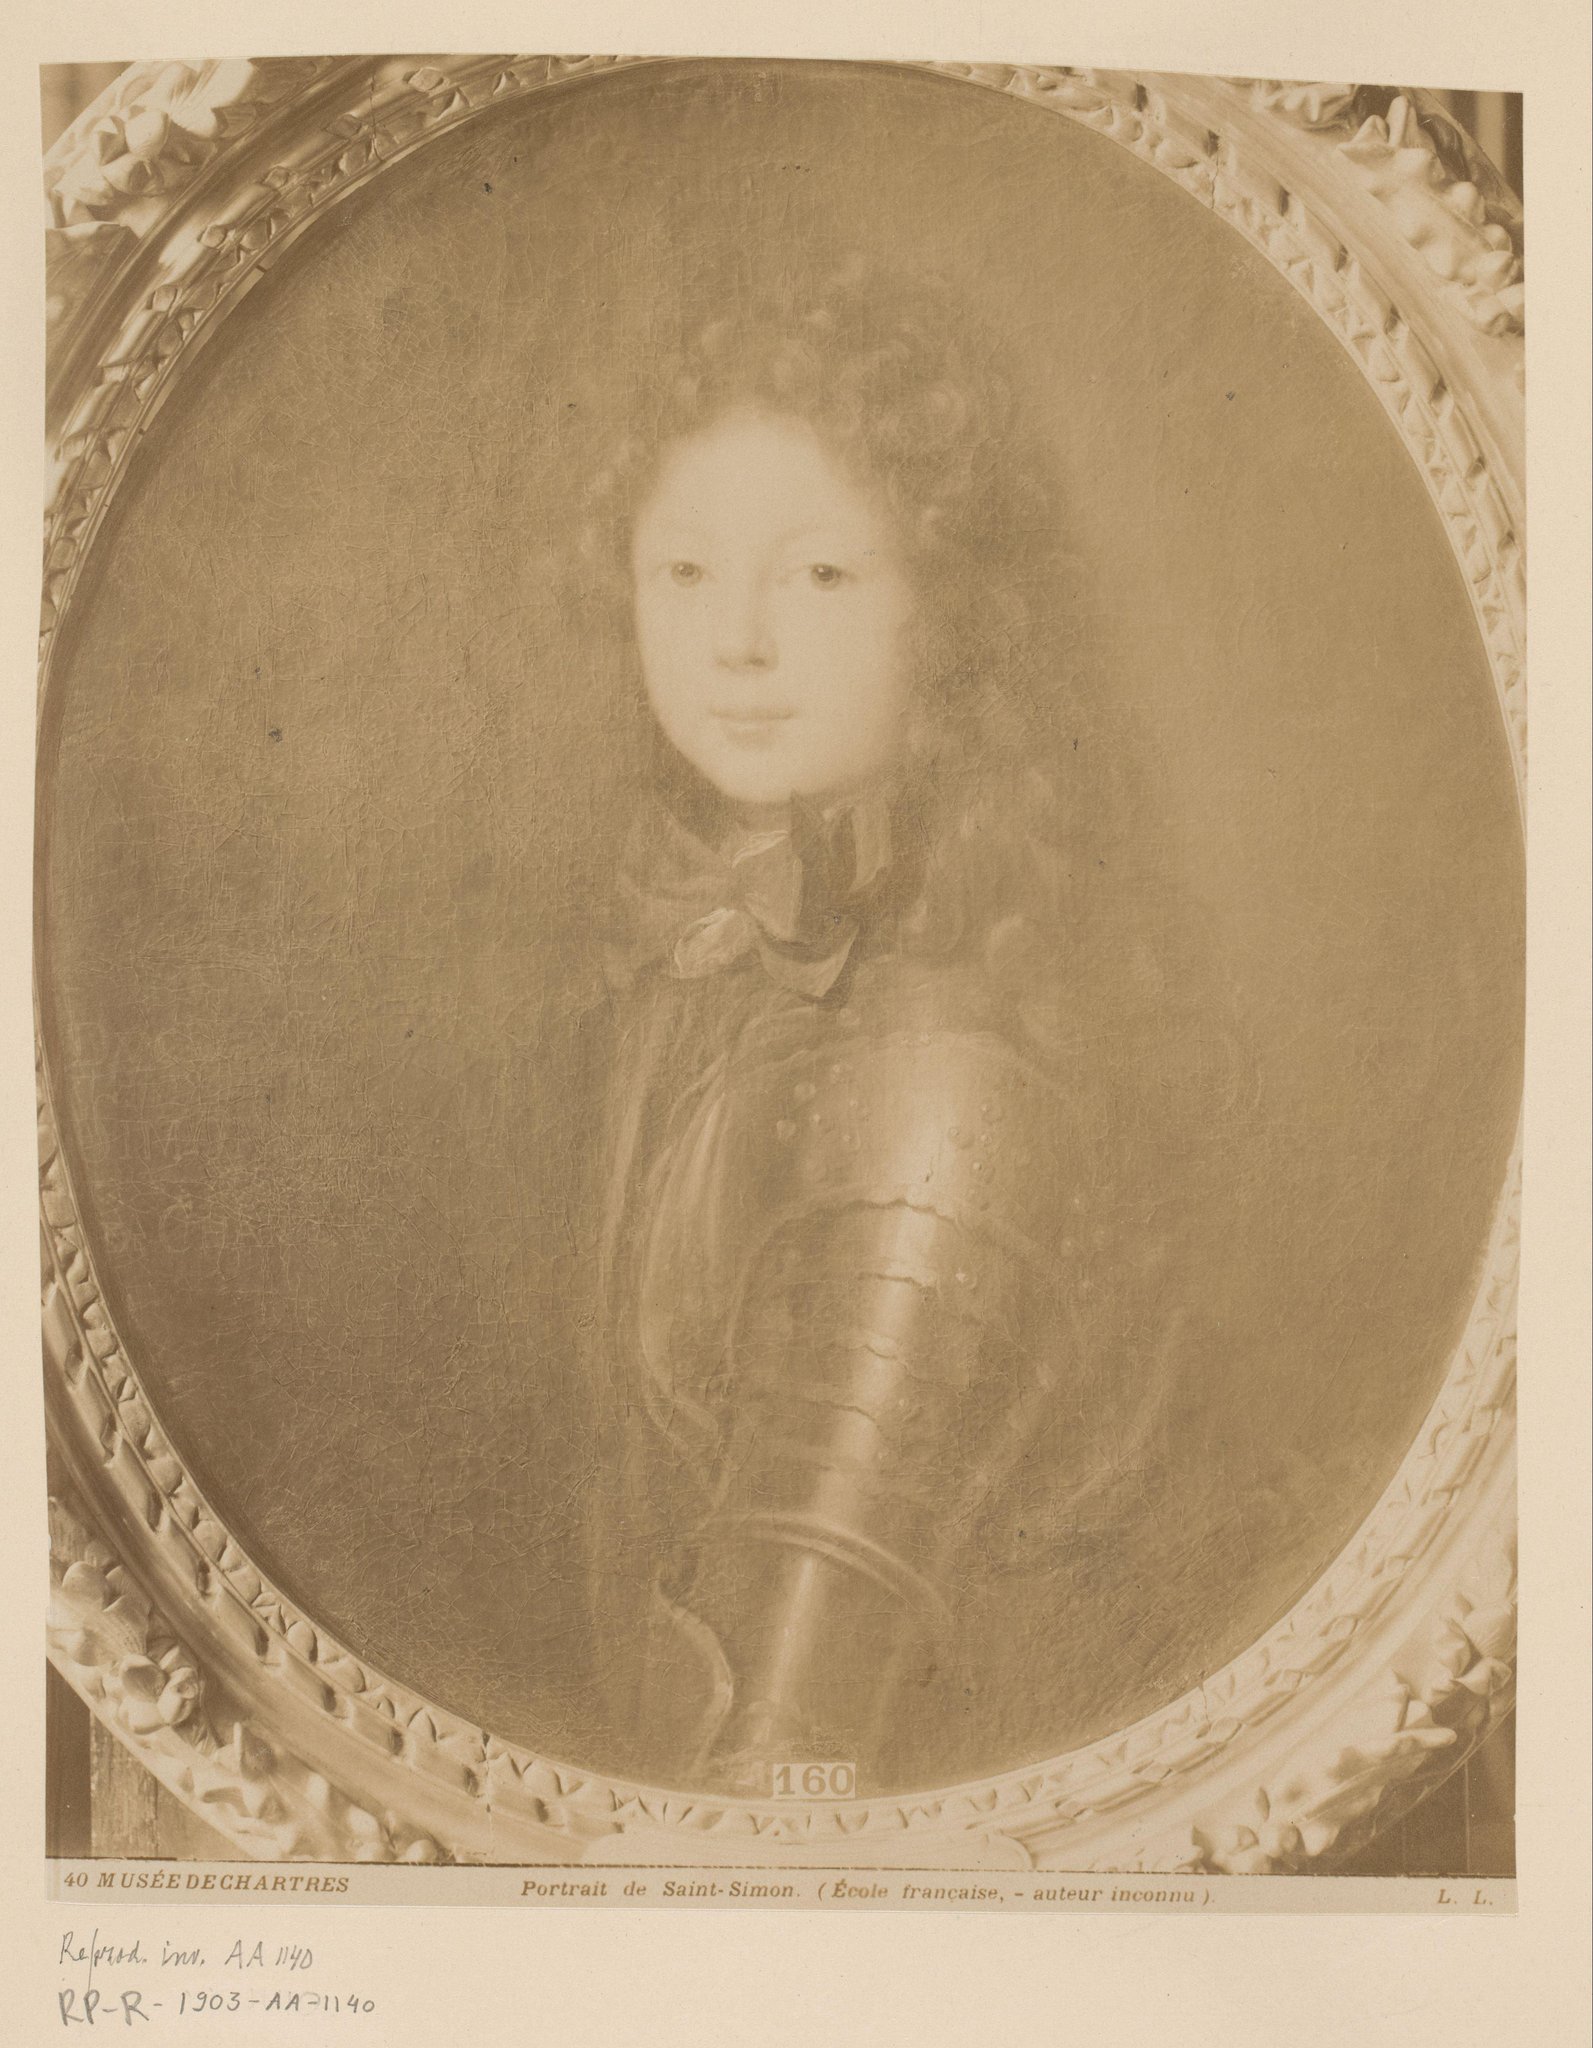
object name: reproduction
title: Fotoreproductie van een geschilderd portret van Louis de Rouvroy, hertog van Saint-Simon, door Hyacinthe Rigaud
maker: Anonymous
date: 1886-1895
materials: cardboard, paper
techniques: albumen print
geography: paris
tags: historical persons, regent, substitute ruler; viceroy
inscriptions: number: ‘40’, collector's mark: Lugt 2228